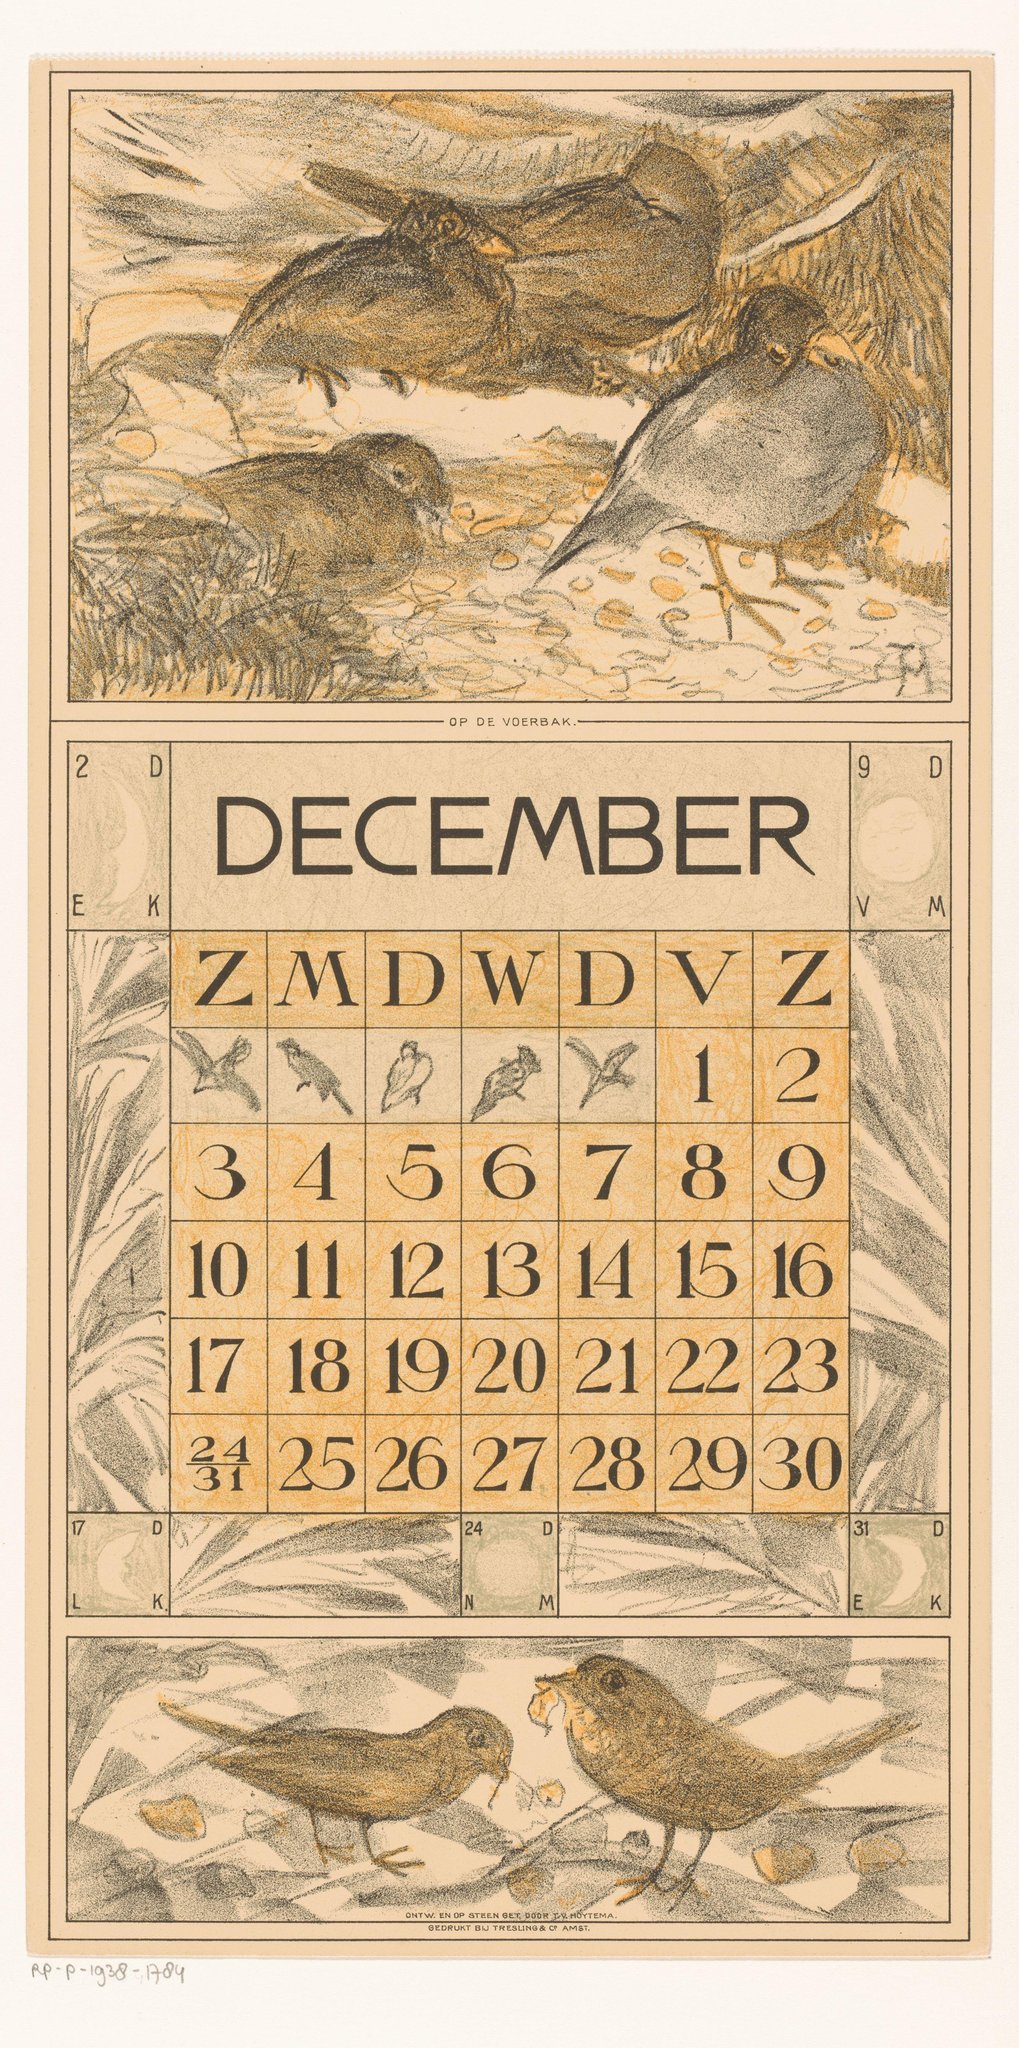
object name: calendar leaf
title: Kalender 1916 12 lithografien door Th. v. Hoytema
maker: theo van hoytema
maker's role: draughtsman, painter, print maker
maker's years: 1863-1917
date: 1915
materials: paper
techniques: lithograph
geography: amsterdam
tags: birds (+ animals eating and drinking), lunar year, december ~ other concepts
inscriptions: collector's mark: Lugt 2228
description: In de hoeken de standen van de maan op vier dagen. Bovenaan het blad een scheurlijn.